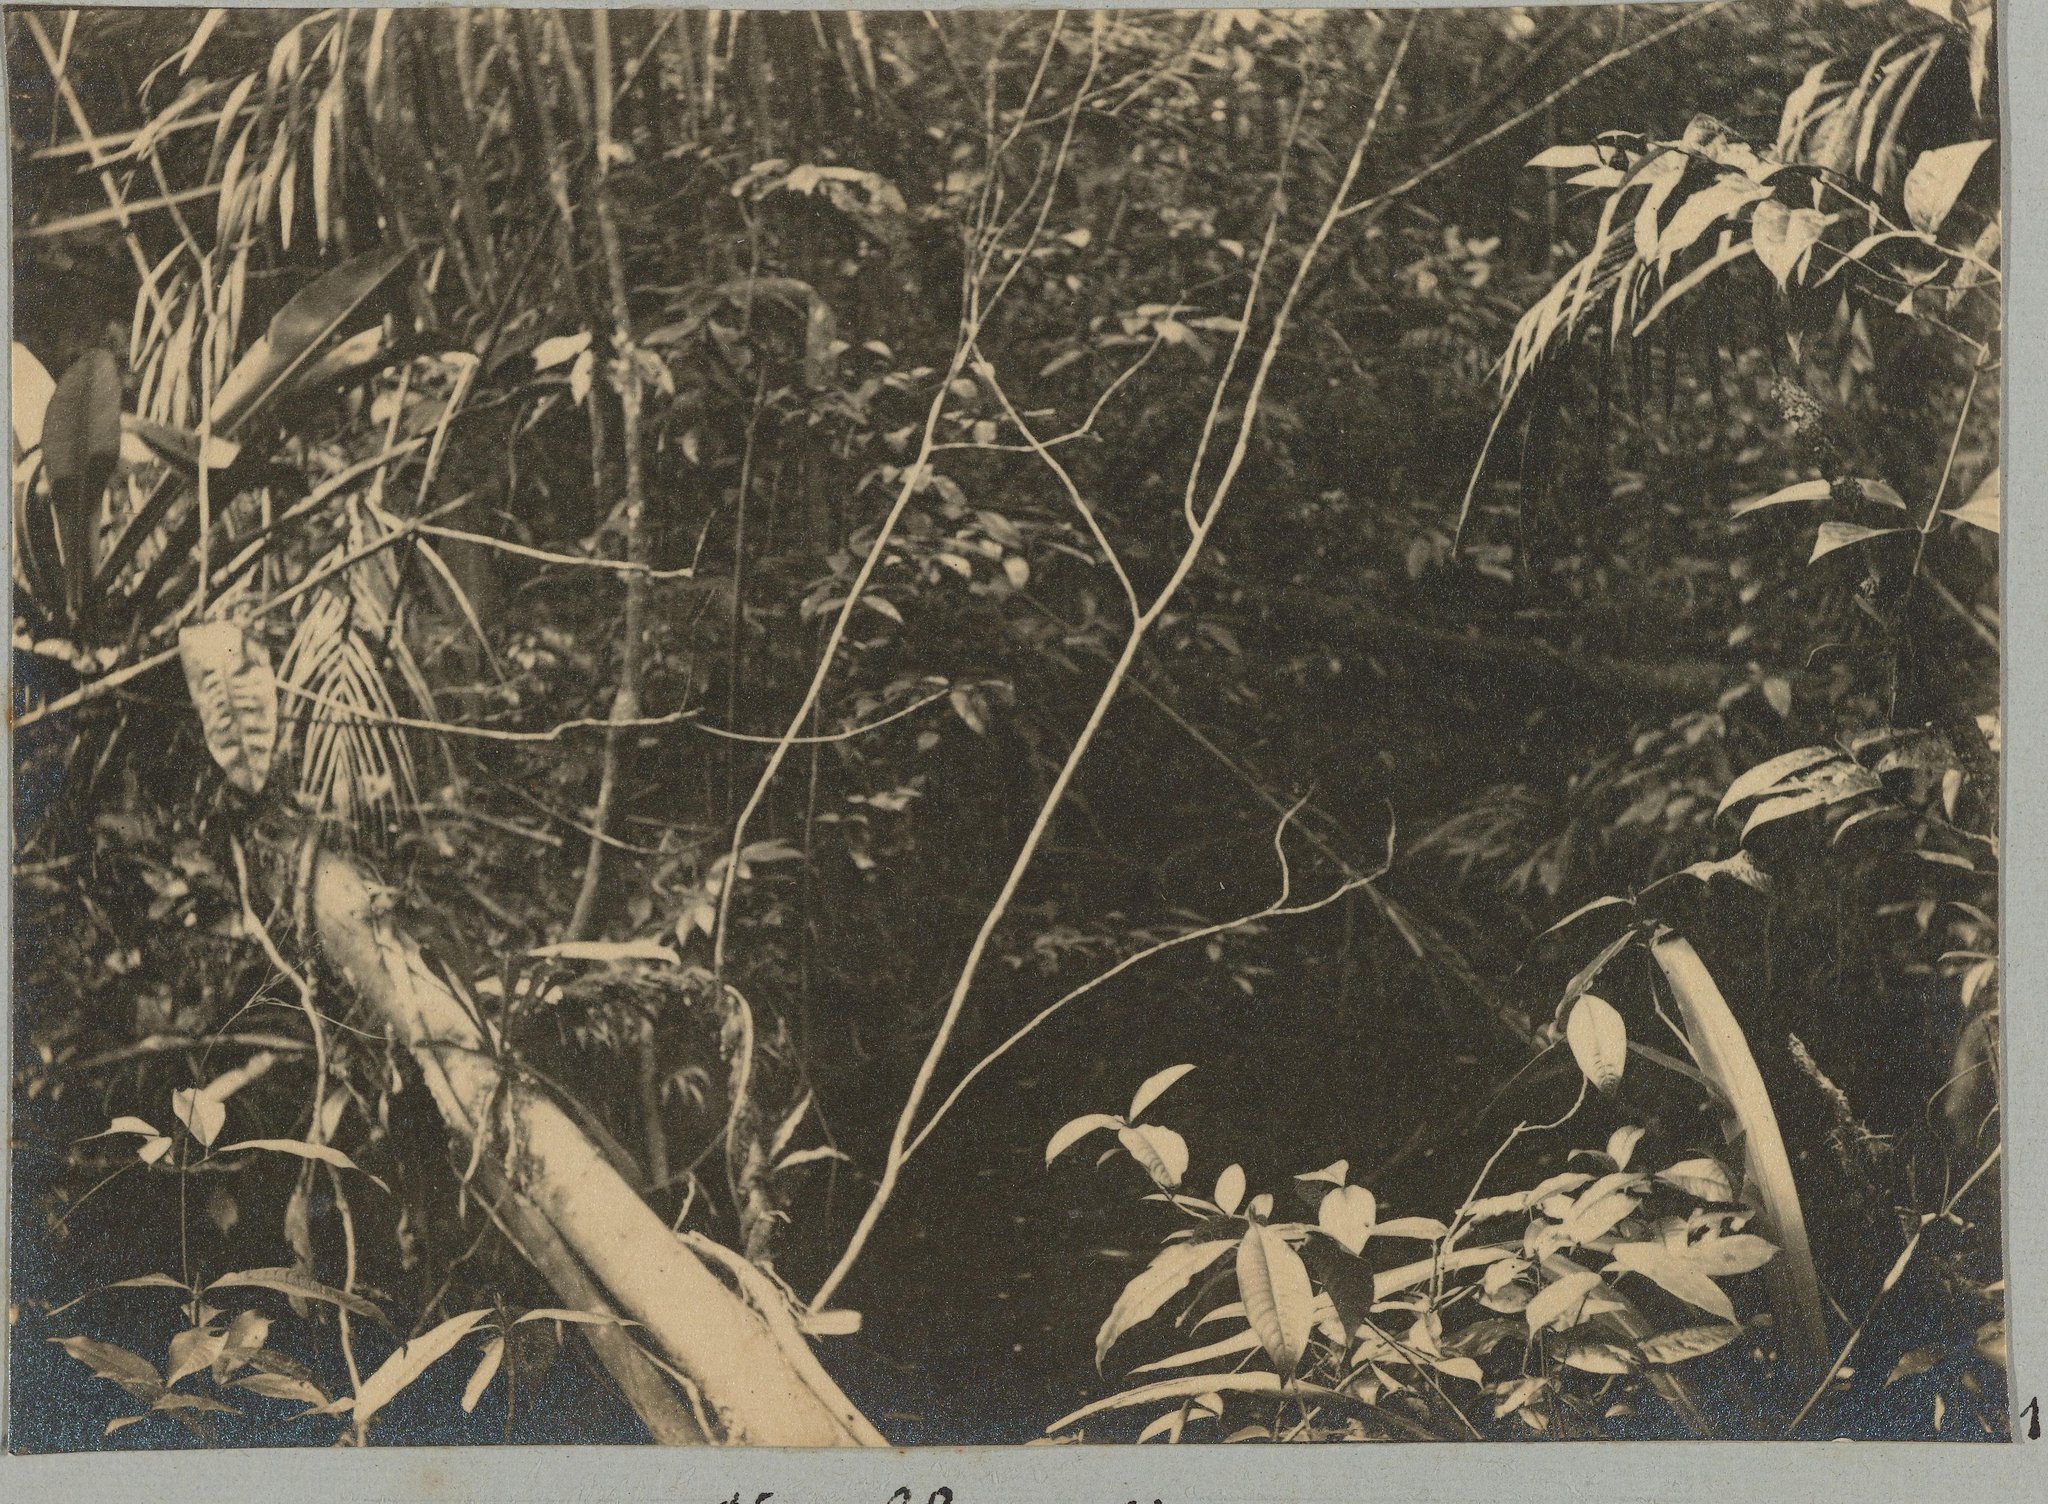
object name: photograph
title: Kreekbegroeiing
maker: hendrik doijer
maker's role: engineer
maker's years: 1863-1925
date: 1903-1910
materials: photographic support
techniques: gelatin silver print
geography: suriname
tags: suriname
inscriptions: inscription: ‘15. / Kreekbegroeiing.’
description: Plantengroei bij een beek. Onderdeel van het fotoalbum Souvenir de Voyage (deel 1), over het leven van de familie Doijer in en rond de plantage Ma Retraite in Suriname in de jaren 1903-1910.